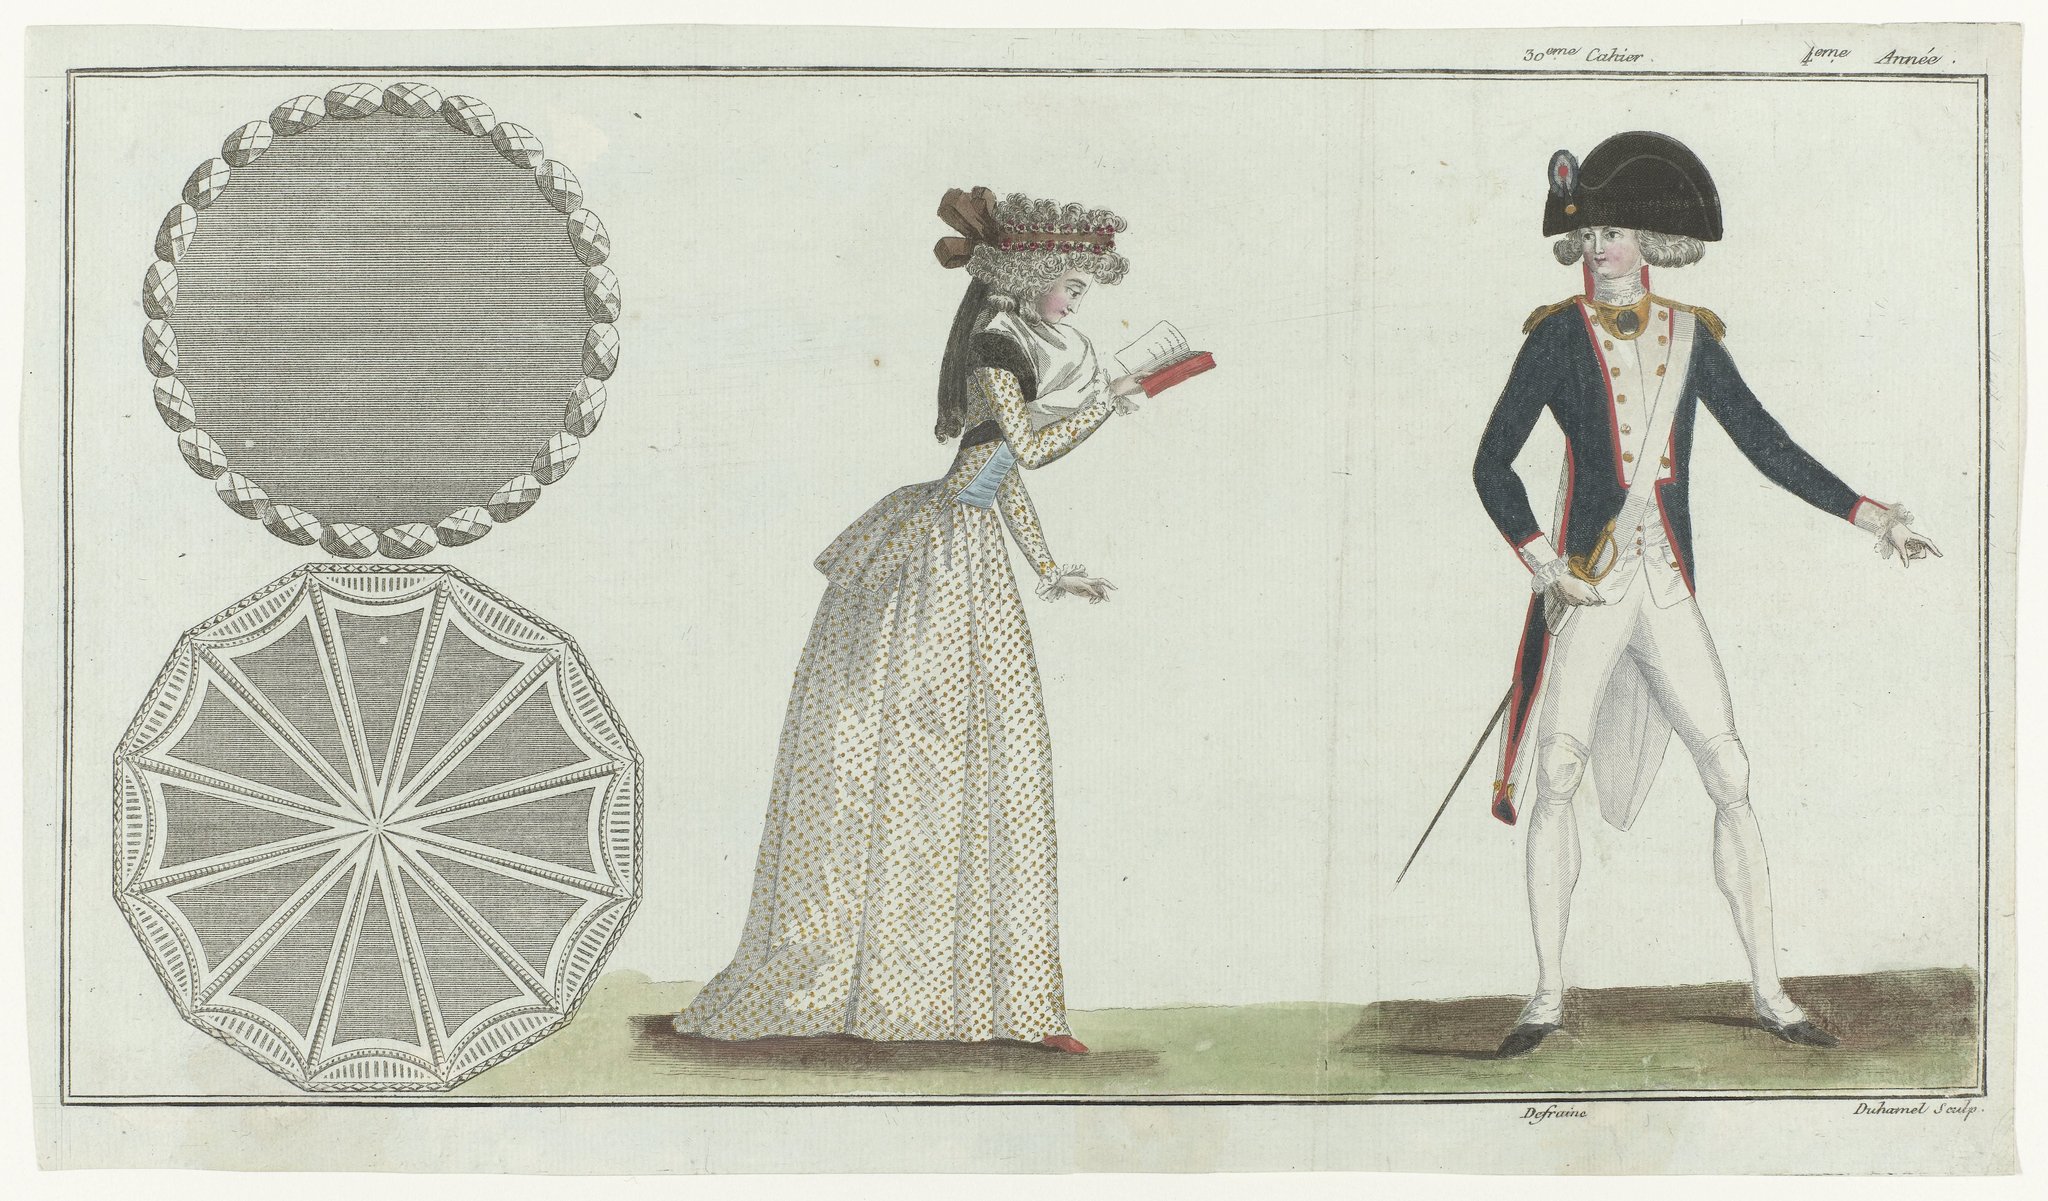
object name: fashion print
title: The First Fashion Magazine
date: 1789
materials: paper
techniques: engraving, hand coloring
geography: paris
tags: clothing for the upper part of the body (caraco) (+ women's clothes), buckle, coat (+ men's clothes), fashion plates, hacking and thrusting weapons: sword, skirt (+ women's clothes), neck-gear: collar (+ lace used for clothes), book - mm - book open, (military) uniforms, trousers, breeches, etc. (breeches) (+ men's clothes), piece of clothing covering the breast or décolleté (fichu) (+ women's clothes), head-gear: bicorne, bicorn (+ men's clothes)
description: The Cabinet des Modes ou les Modes Nouvelles first appeared on 15 November 1785. As the first real fashion magazine, it was published on a regular basis and wholly dedicated to news from the world of fashion. It was available by subscription only and distributed both in France and abroad. Each eight-page edition contained three hand-coloured engravings. After a year in print, the magazine changed its name to Magasin des Modes Nouvelles Françaises et Anglaises. Instead of three loose sheets, it now included a single fold-out plate depicting clothes and accessories. Publication of the Magasin ceased abruptly in 1789; after this, it was most likely succeeded by the Journal de la Mode et du Goût.